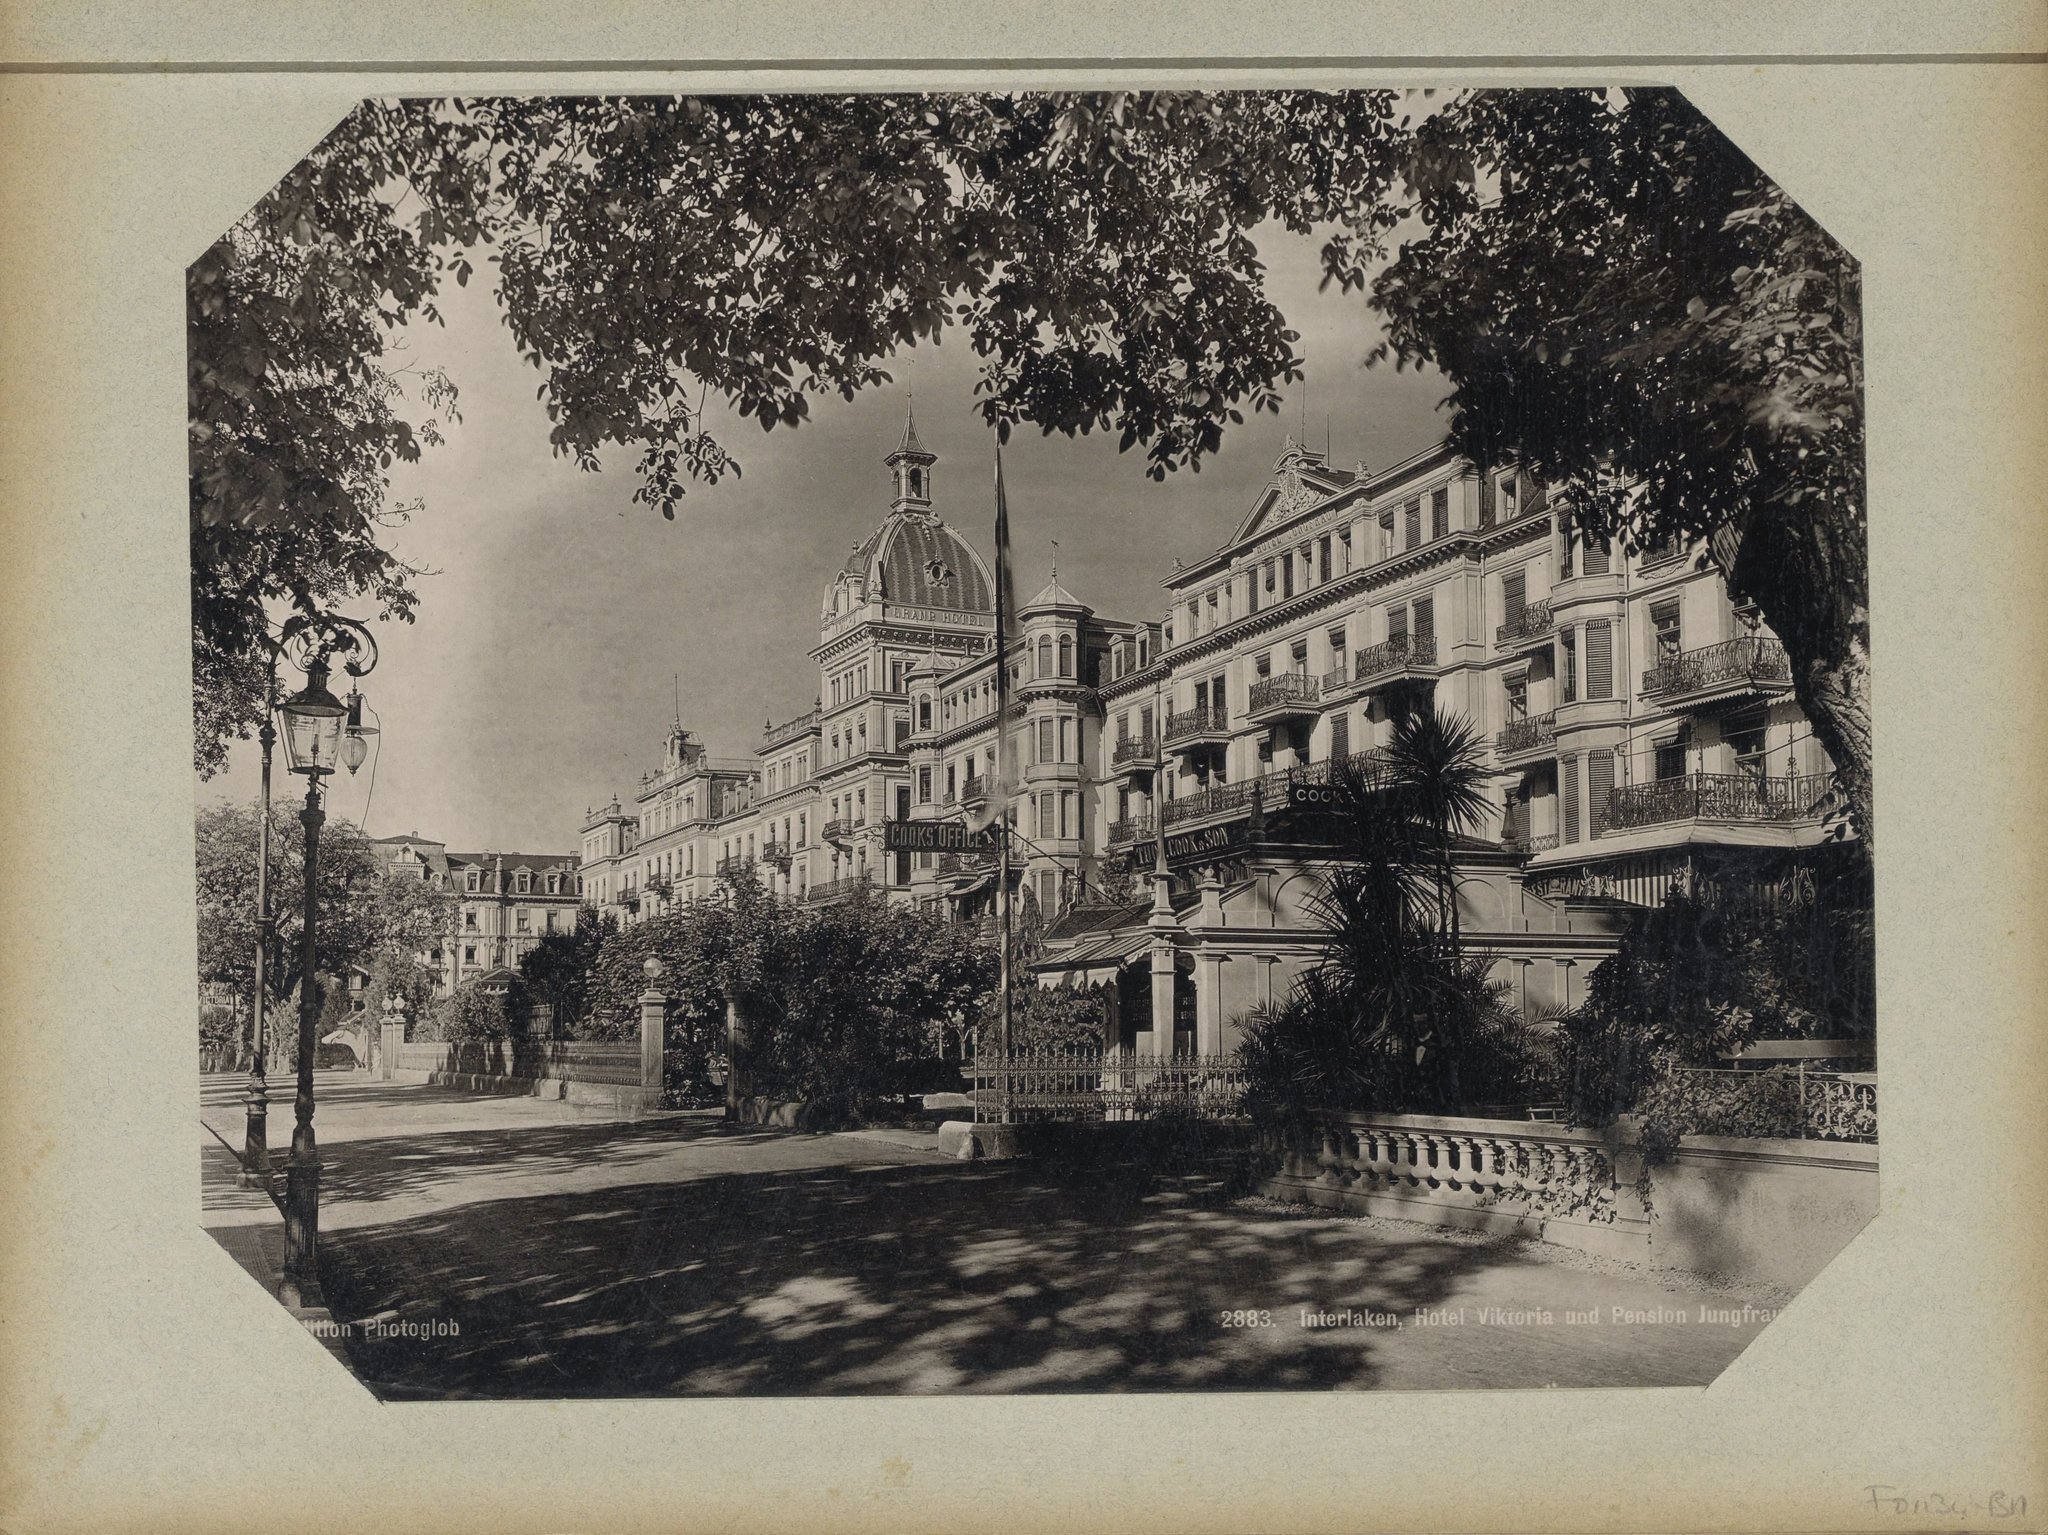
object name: album leaf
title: Gebouwen van Hotel Viktoria, Pension Jungfrau en Thomas Cook & Son in Interlaken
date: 1880-1910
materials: paper, ink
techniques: photograph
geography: interlaken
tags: travelling; tourism, hotel, hostelry, inn, street (+ city(-scape) with figures, staffage)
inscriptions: stamp: ‘Dépôt M. Stump Editeur Interlaken (Suisse)’, number: ‘2883’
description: Onderdeel van Reisalbum met bezienswaardigheden in Engeland, Zwitserland, Frankrijk en Duitsland.